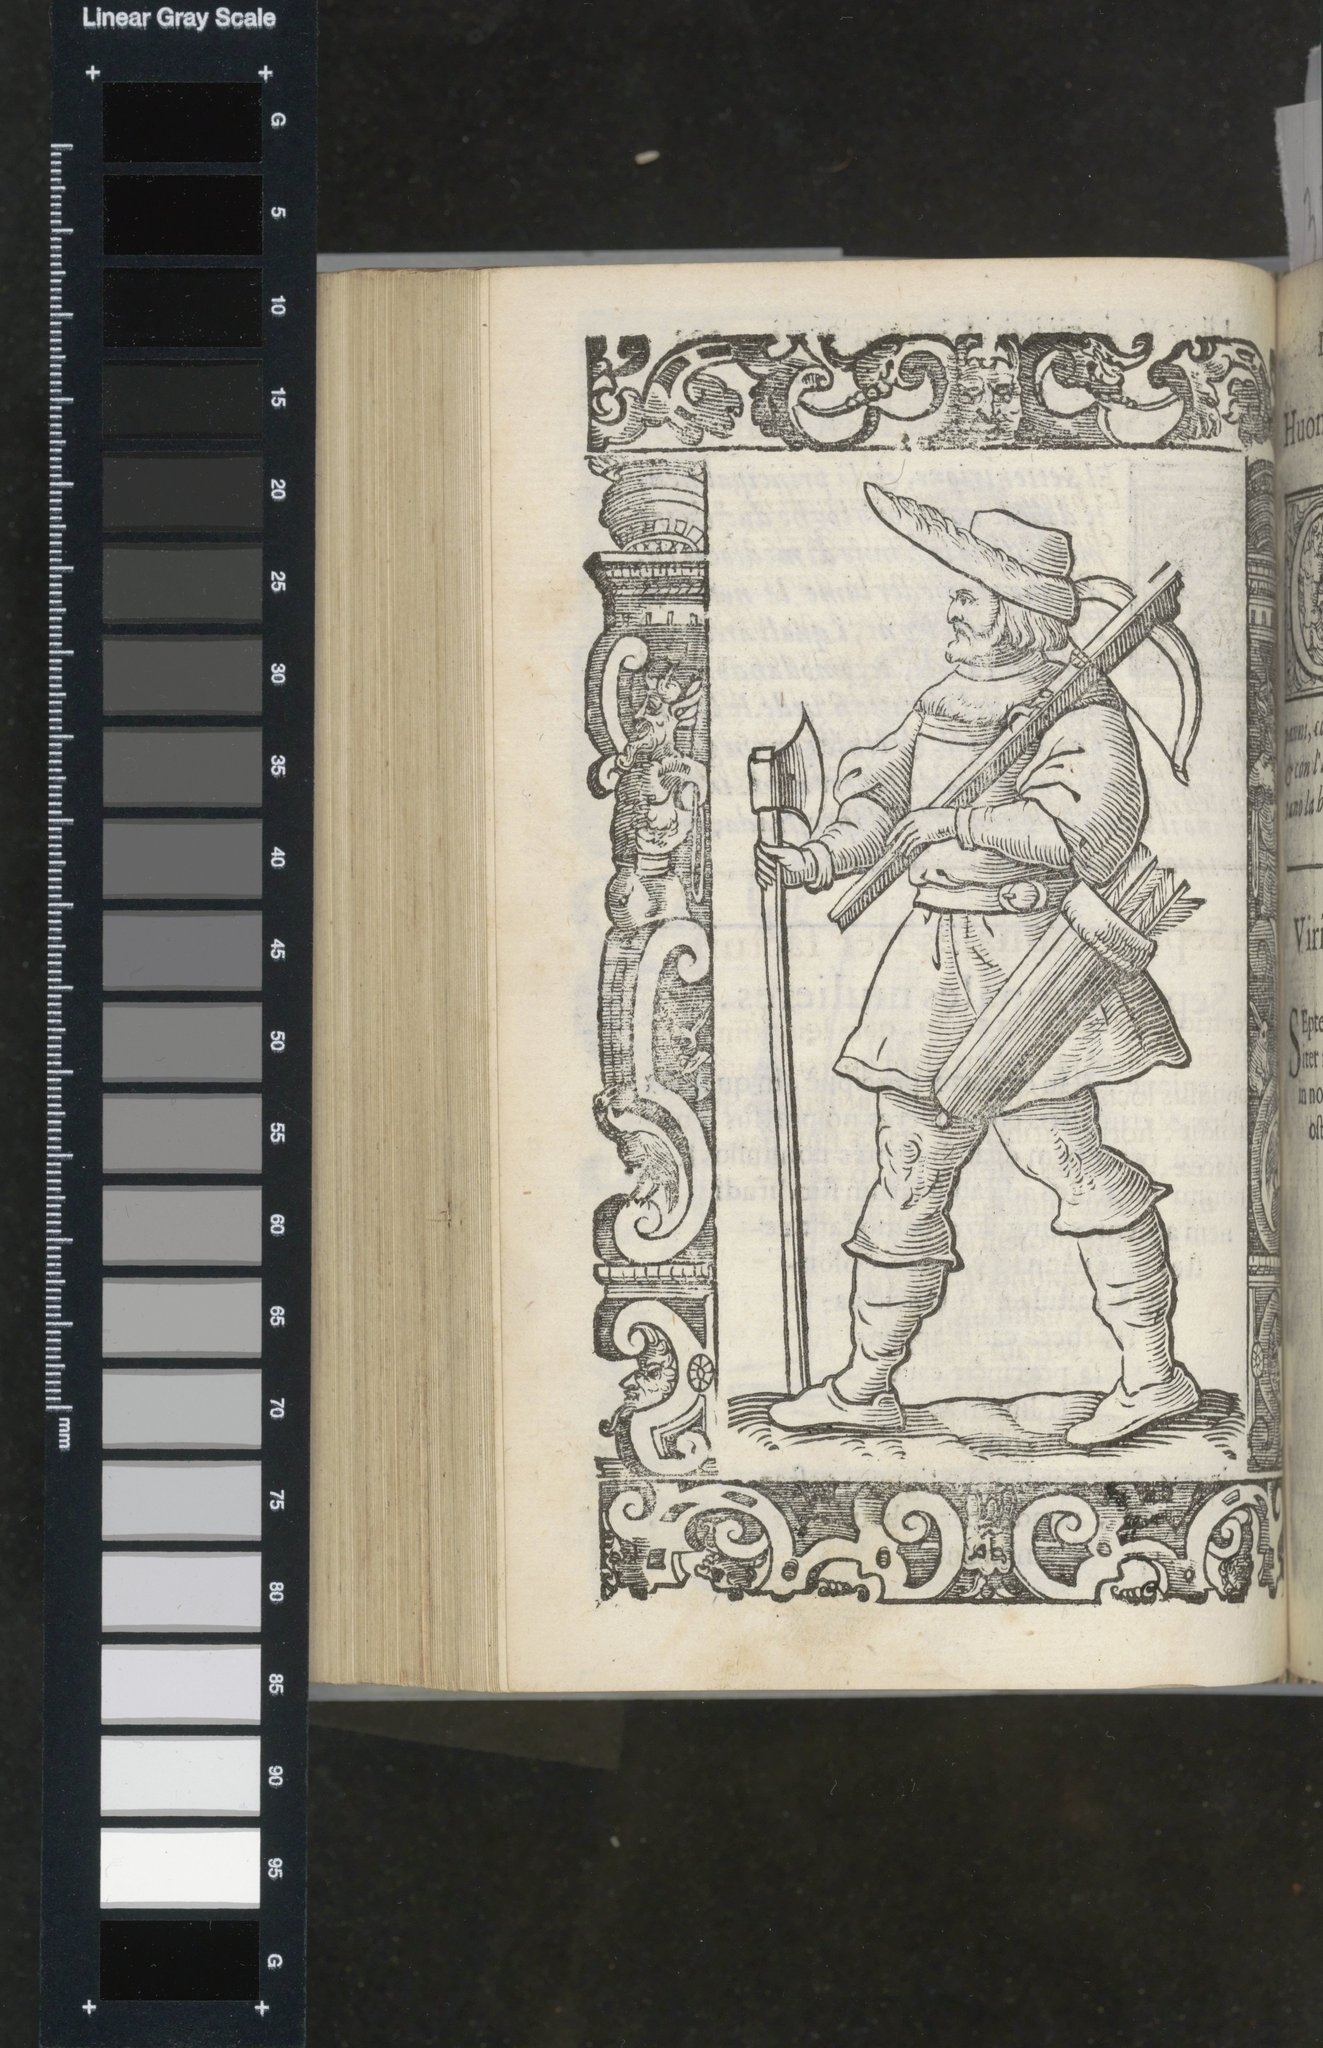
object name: costume print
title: Habiti antichi, et moderni di tutto il mondo...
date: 1598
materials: paper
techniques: woodcut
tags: fashion plates